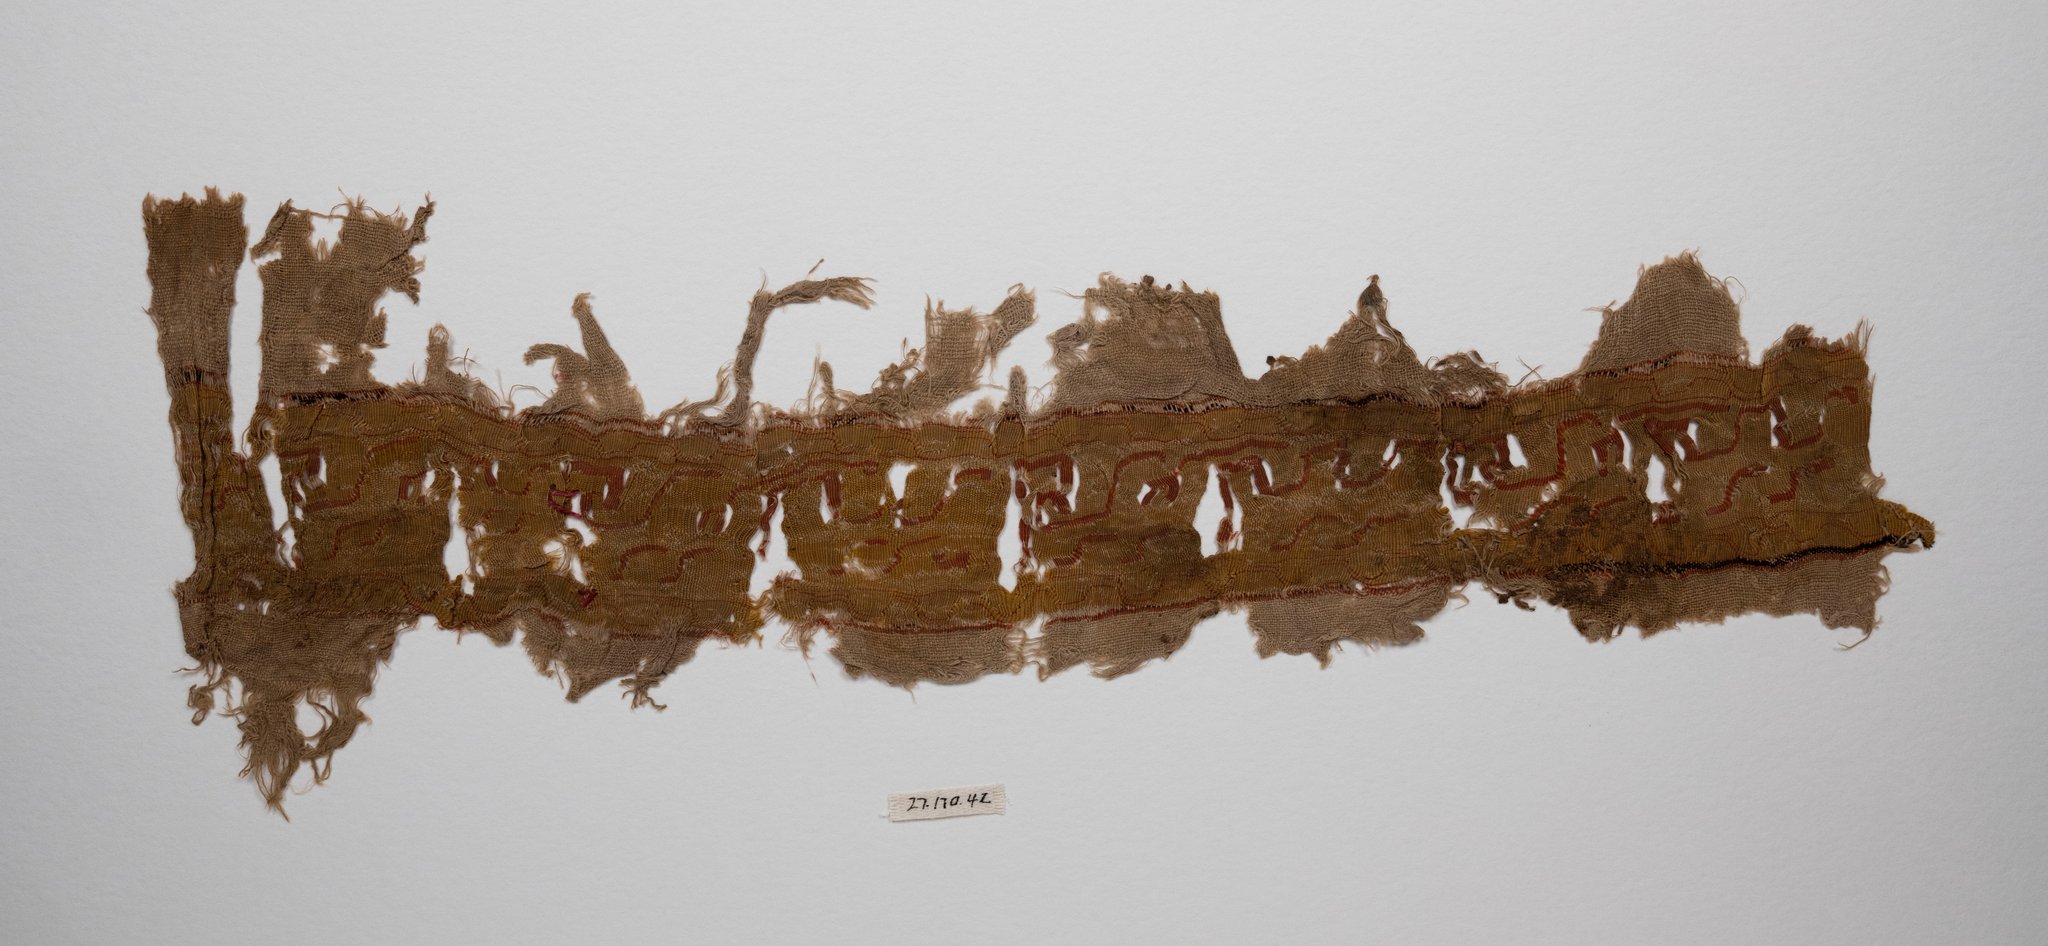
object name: textile fragment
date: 1101-1200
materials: linen, silk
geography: egypt